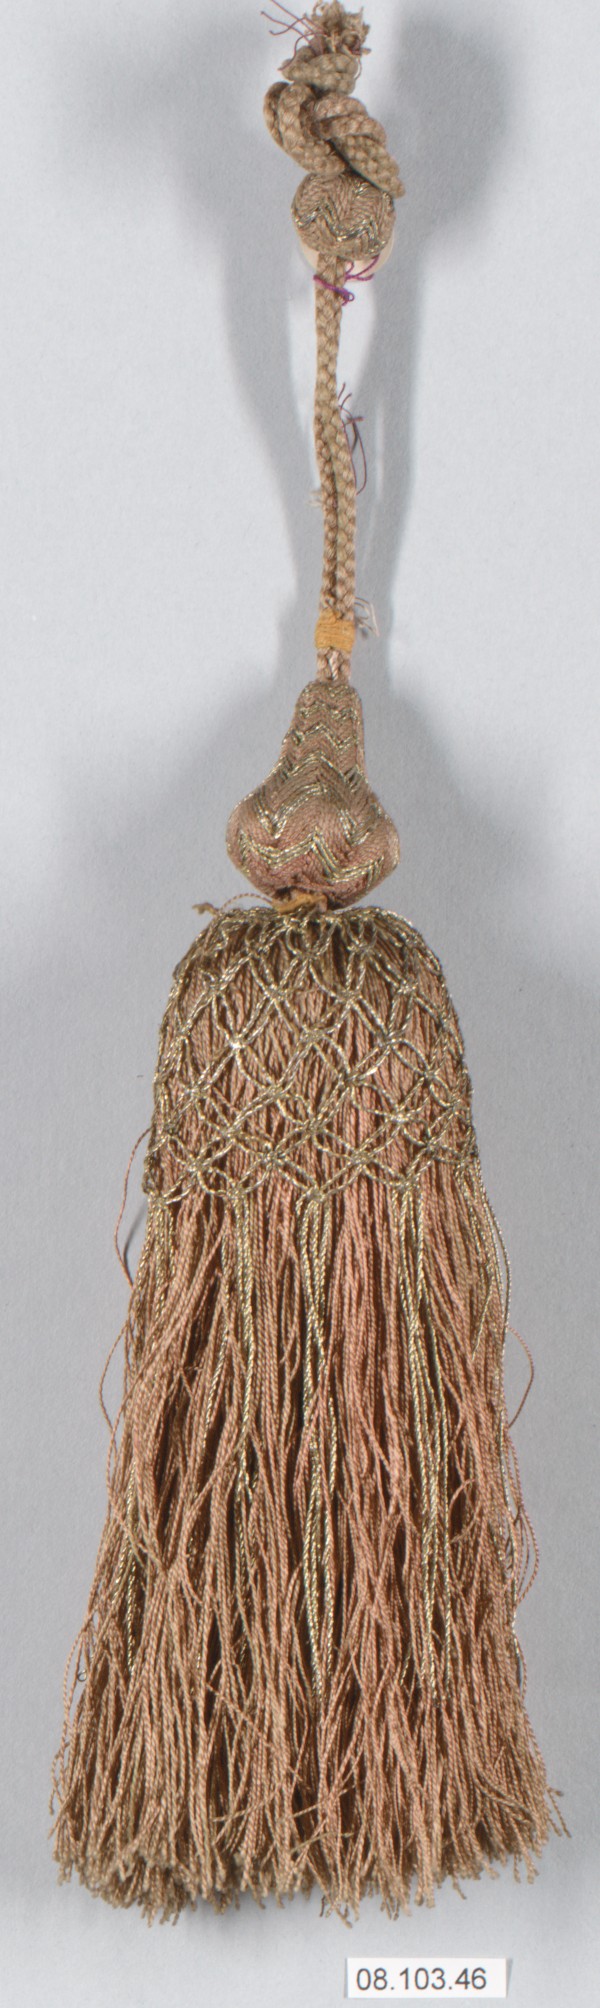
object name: tassel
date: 1567-1633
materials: metal thread, silk